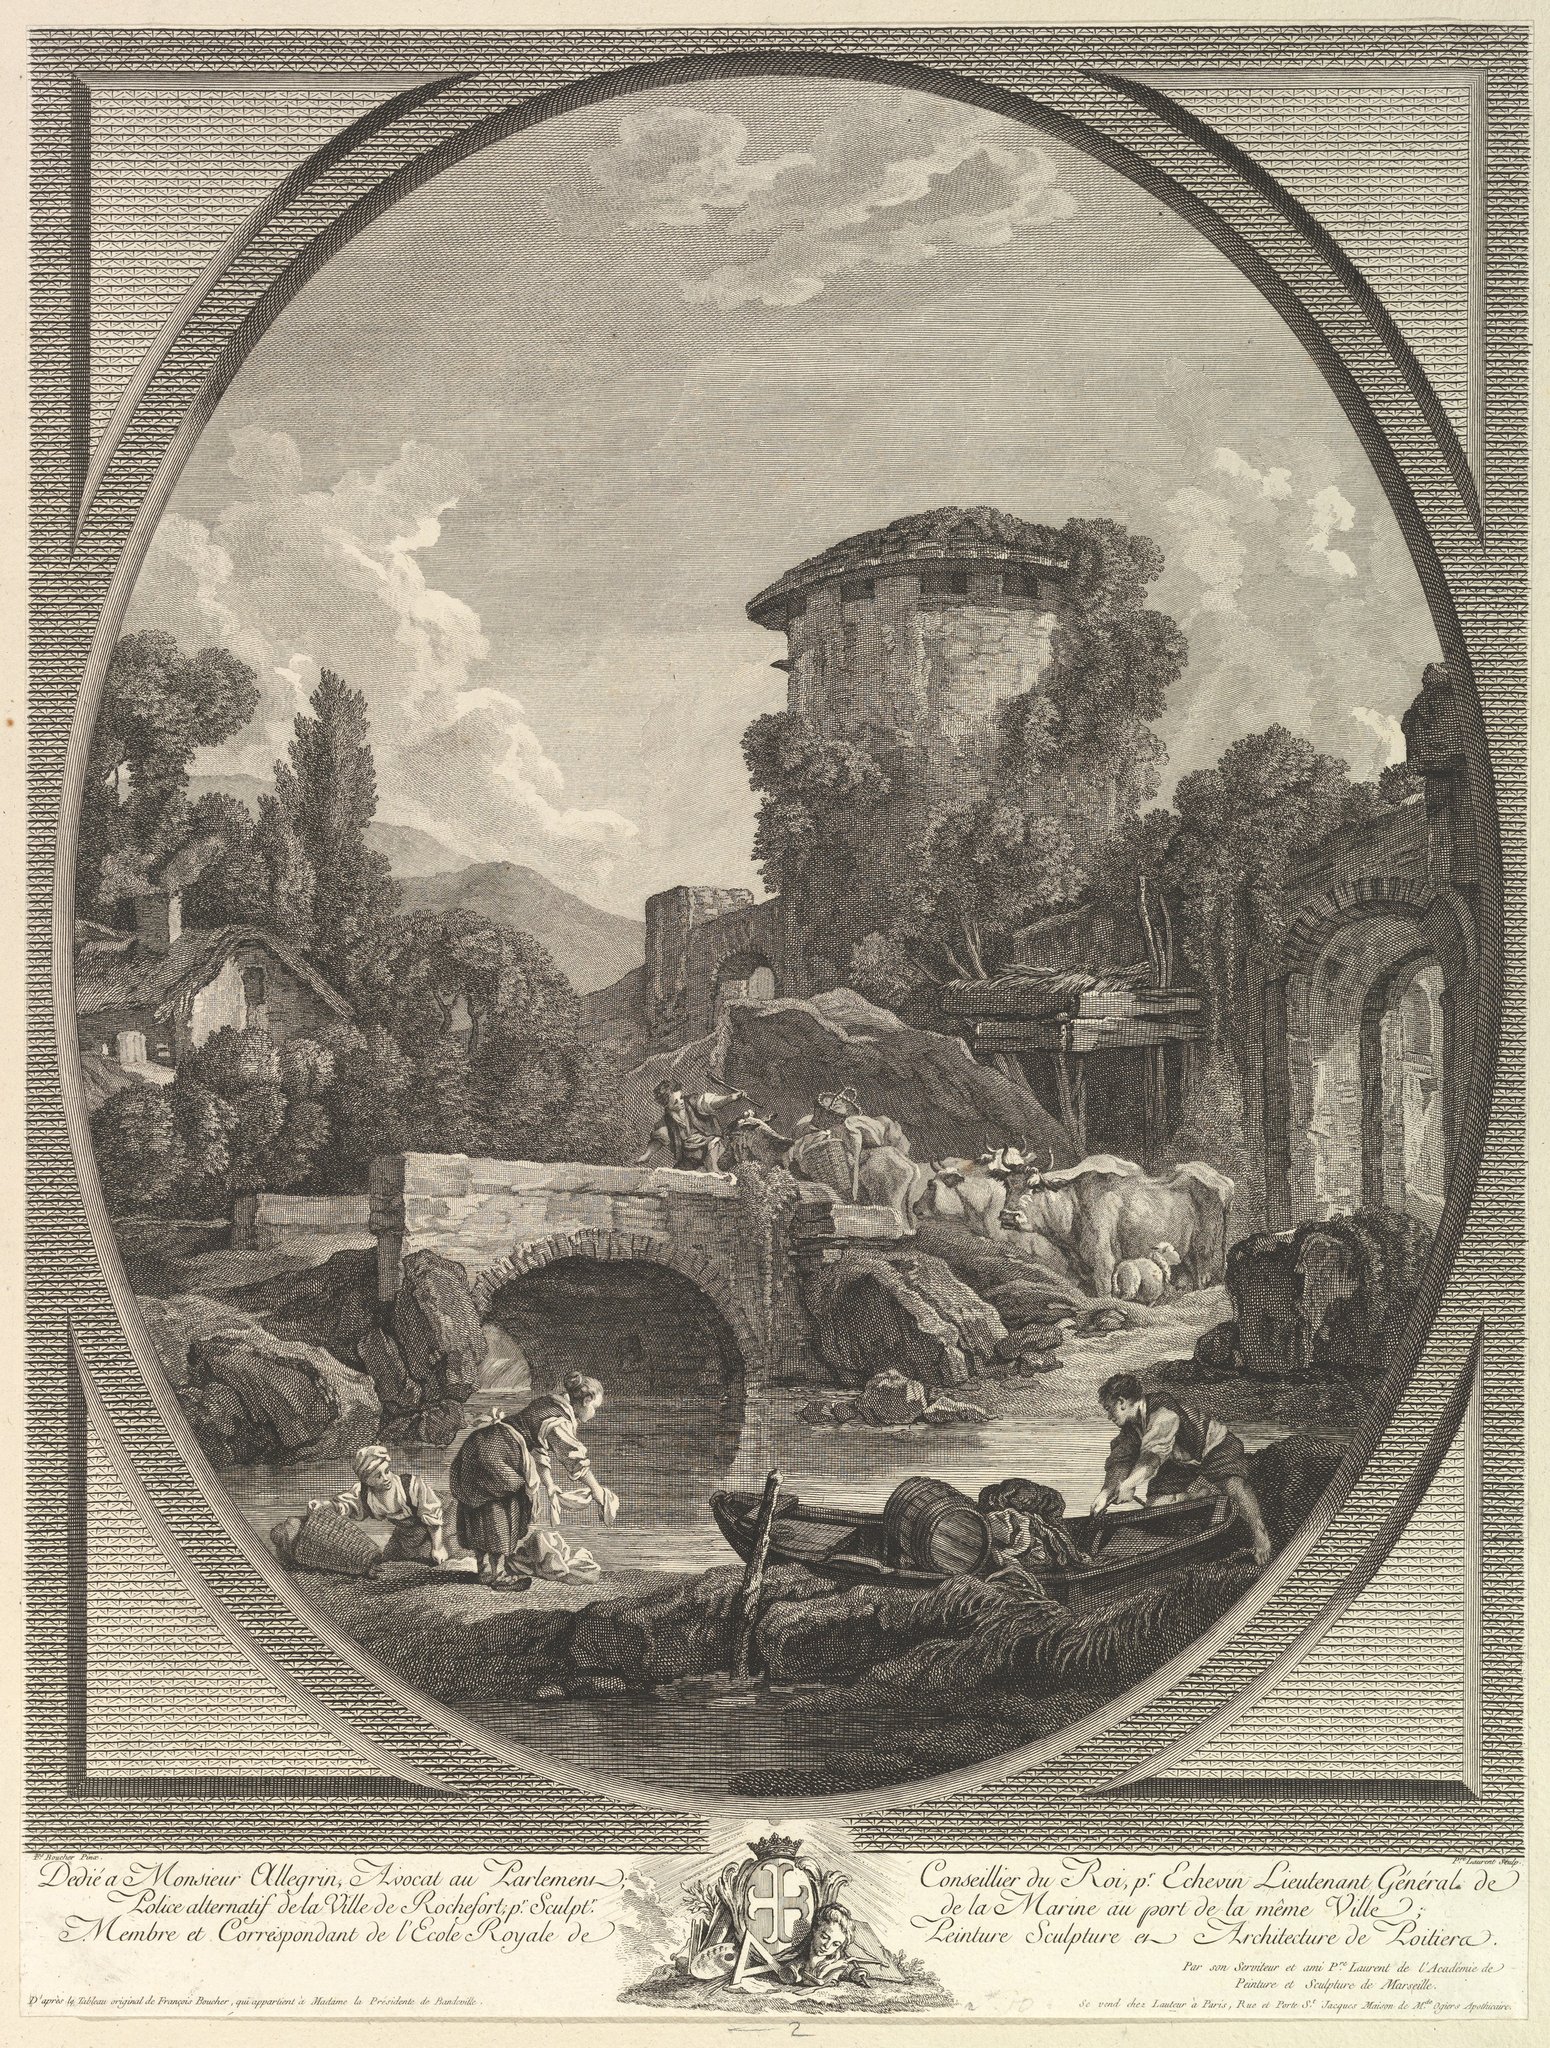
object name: print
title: Paysage au Pont et au Pigeonnier (Landscape with a Bridge and a Dovecote)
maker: pierre françois laurent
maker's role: artist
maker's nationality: french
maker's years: 1739-1809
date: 1701-1800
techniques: engraving, etching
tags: human figures,buildings,bridges,coat of arms,boats